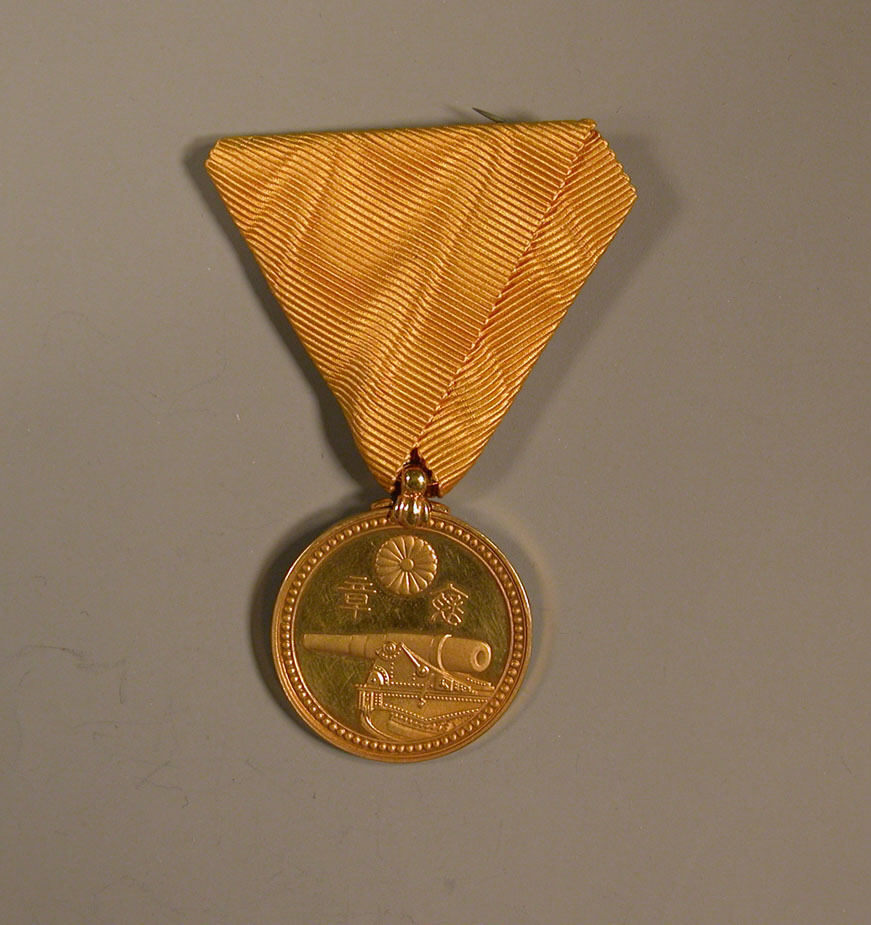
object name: medal of honor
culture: japanese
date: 1867-1900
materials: ribbon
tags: cannons